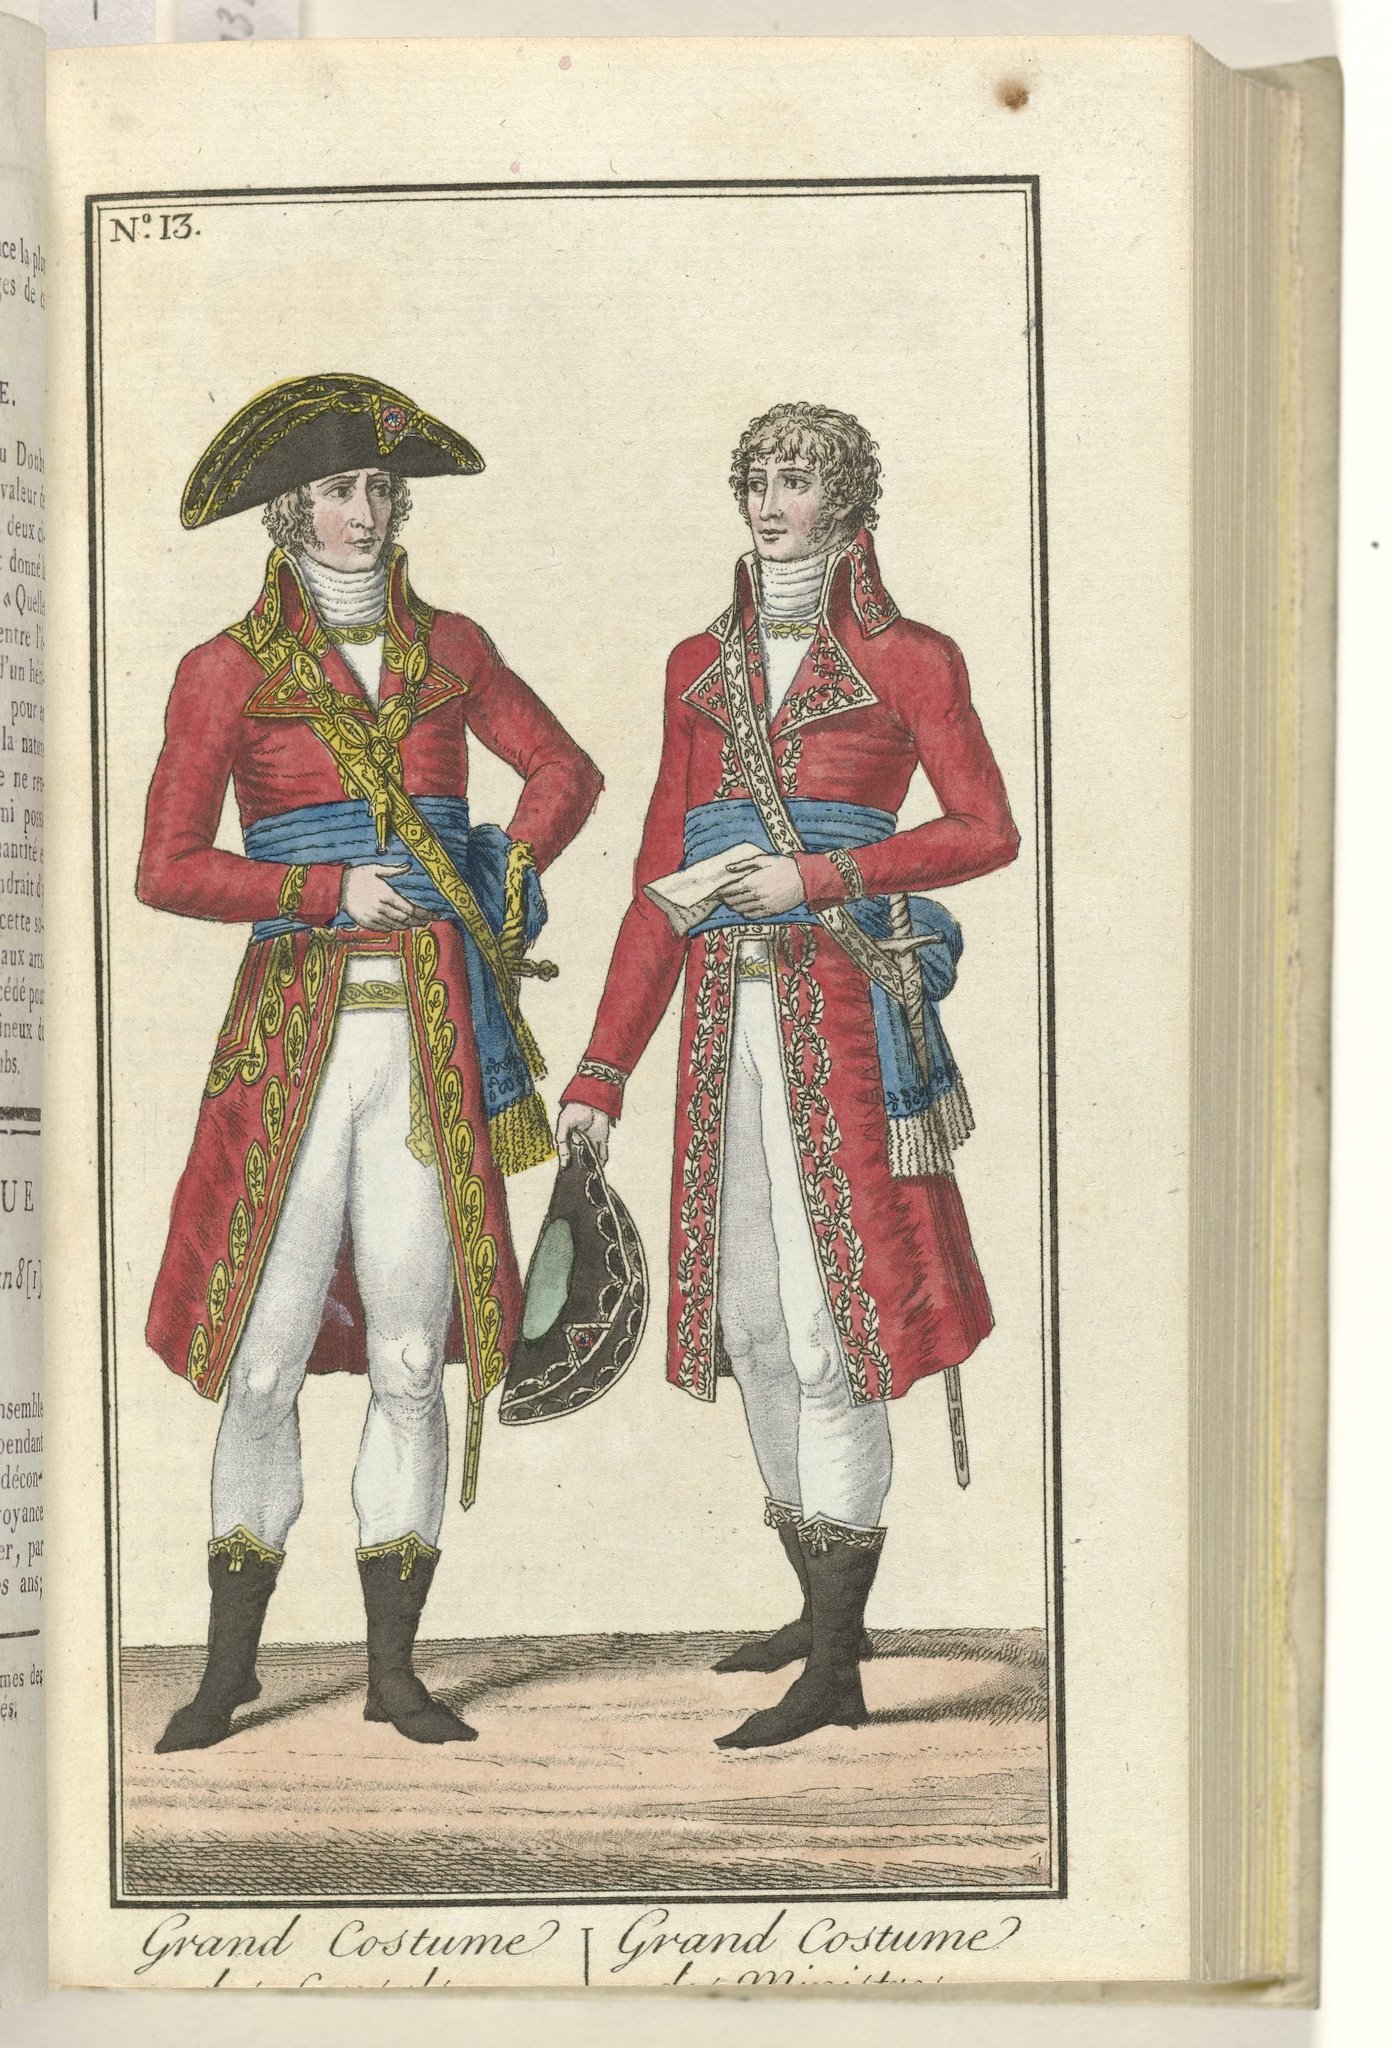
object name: fashion print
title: Le Mois, Journal historique, littéraire et critique, avec figures, no. 13, 1800: Grand Costume du General / Grand Costume du Ministre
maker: Anonymous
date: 1800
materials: paper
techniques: etching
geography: théâtre des folies-marigny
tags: fashion plates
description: Een generaal en een minister, staand naast elkaar. Prent uit het tijdschrift Le mois : journal historique, littéraire et critique avec figures, 1800.